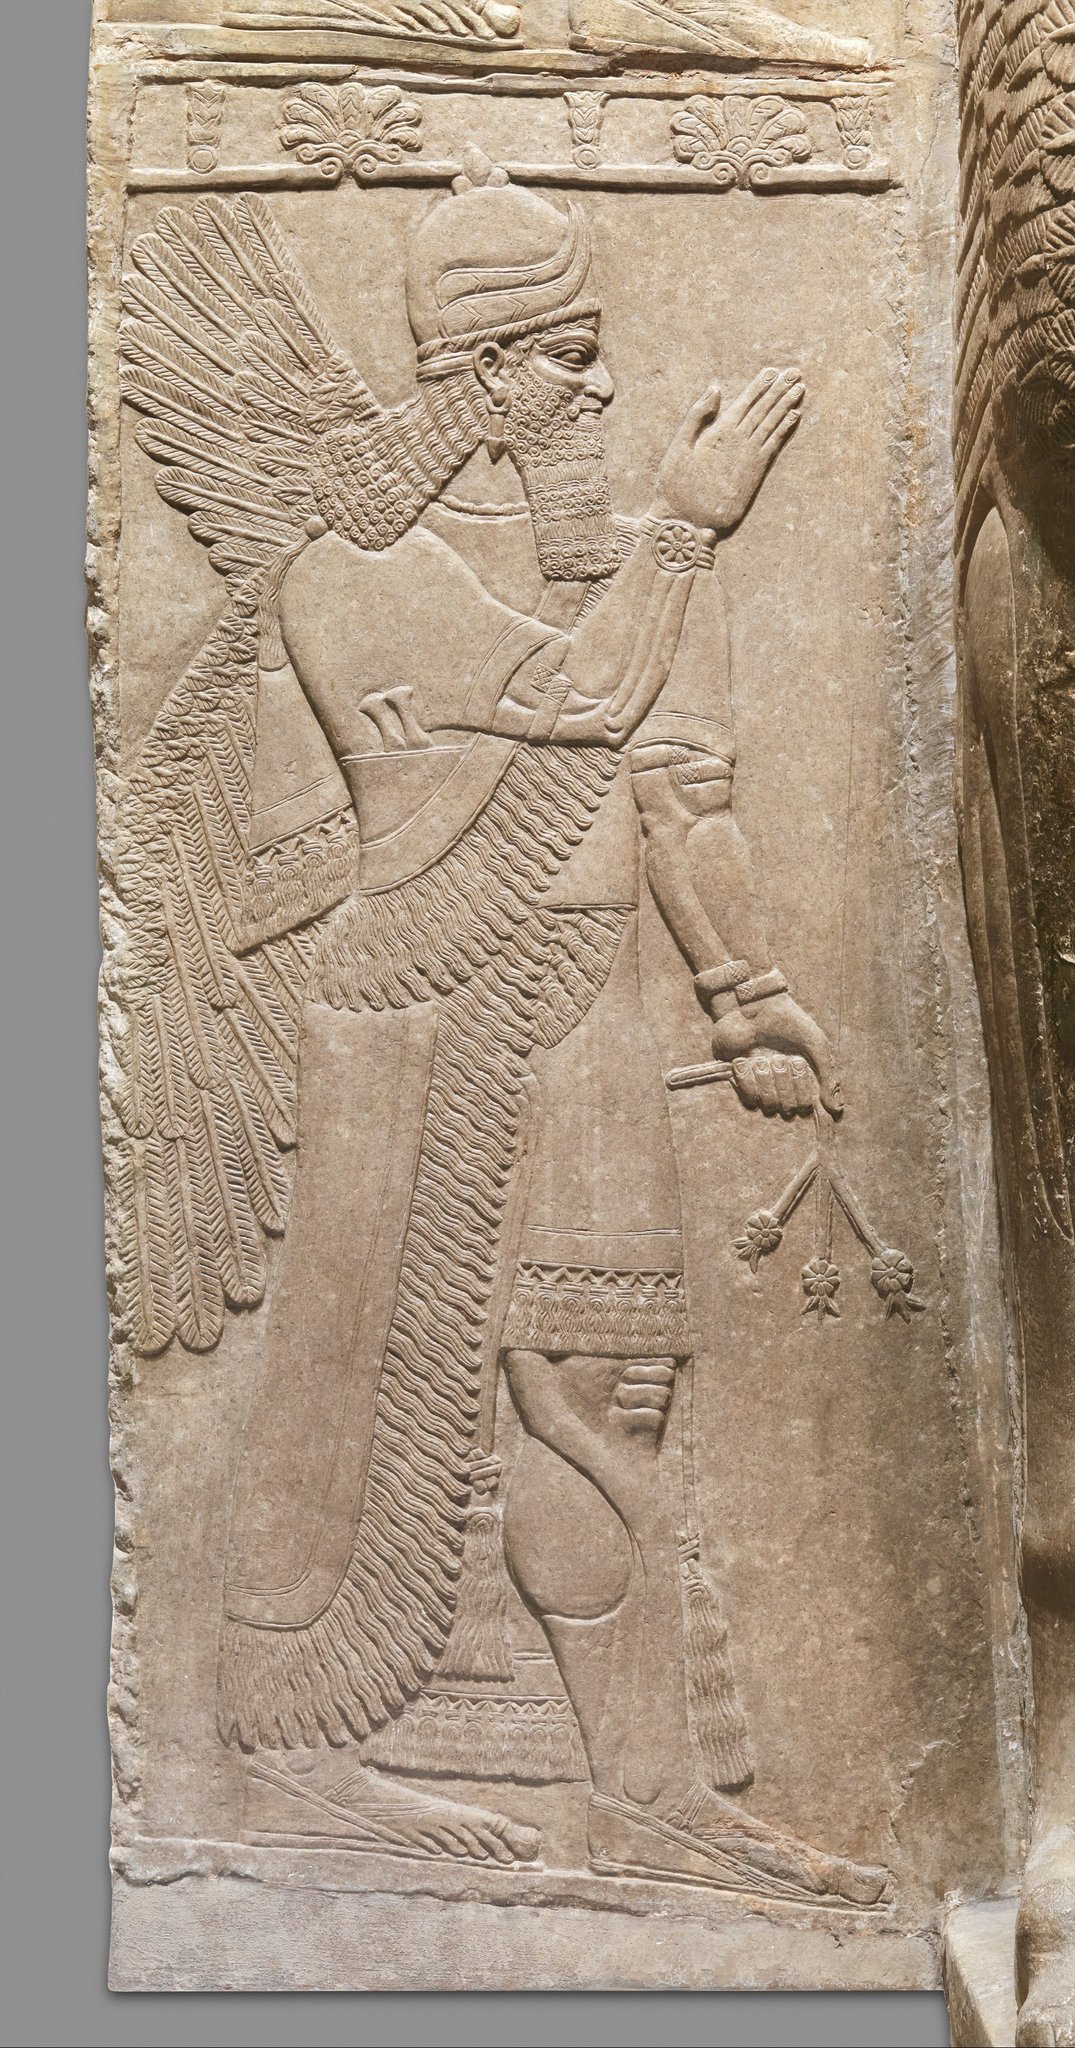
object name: relief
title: Relief panel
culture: assyrian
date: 883-859 BCE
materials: alabaster, gypsum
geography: mesopotamia